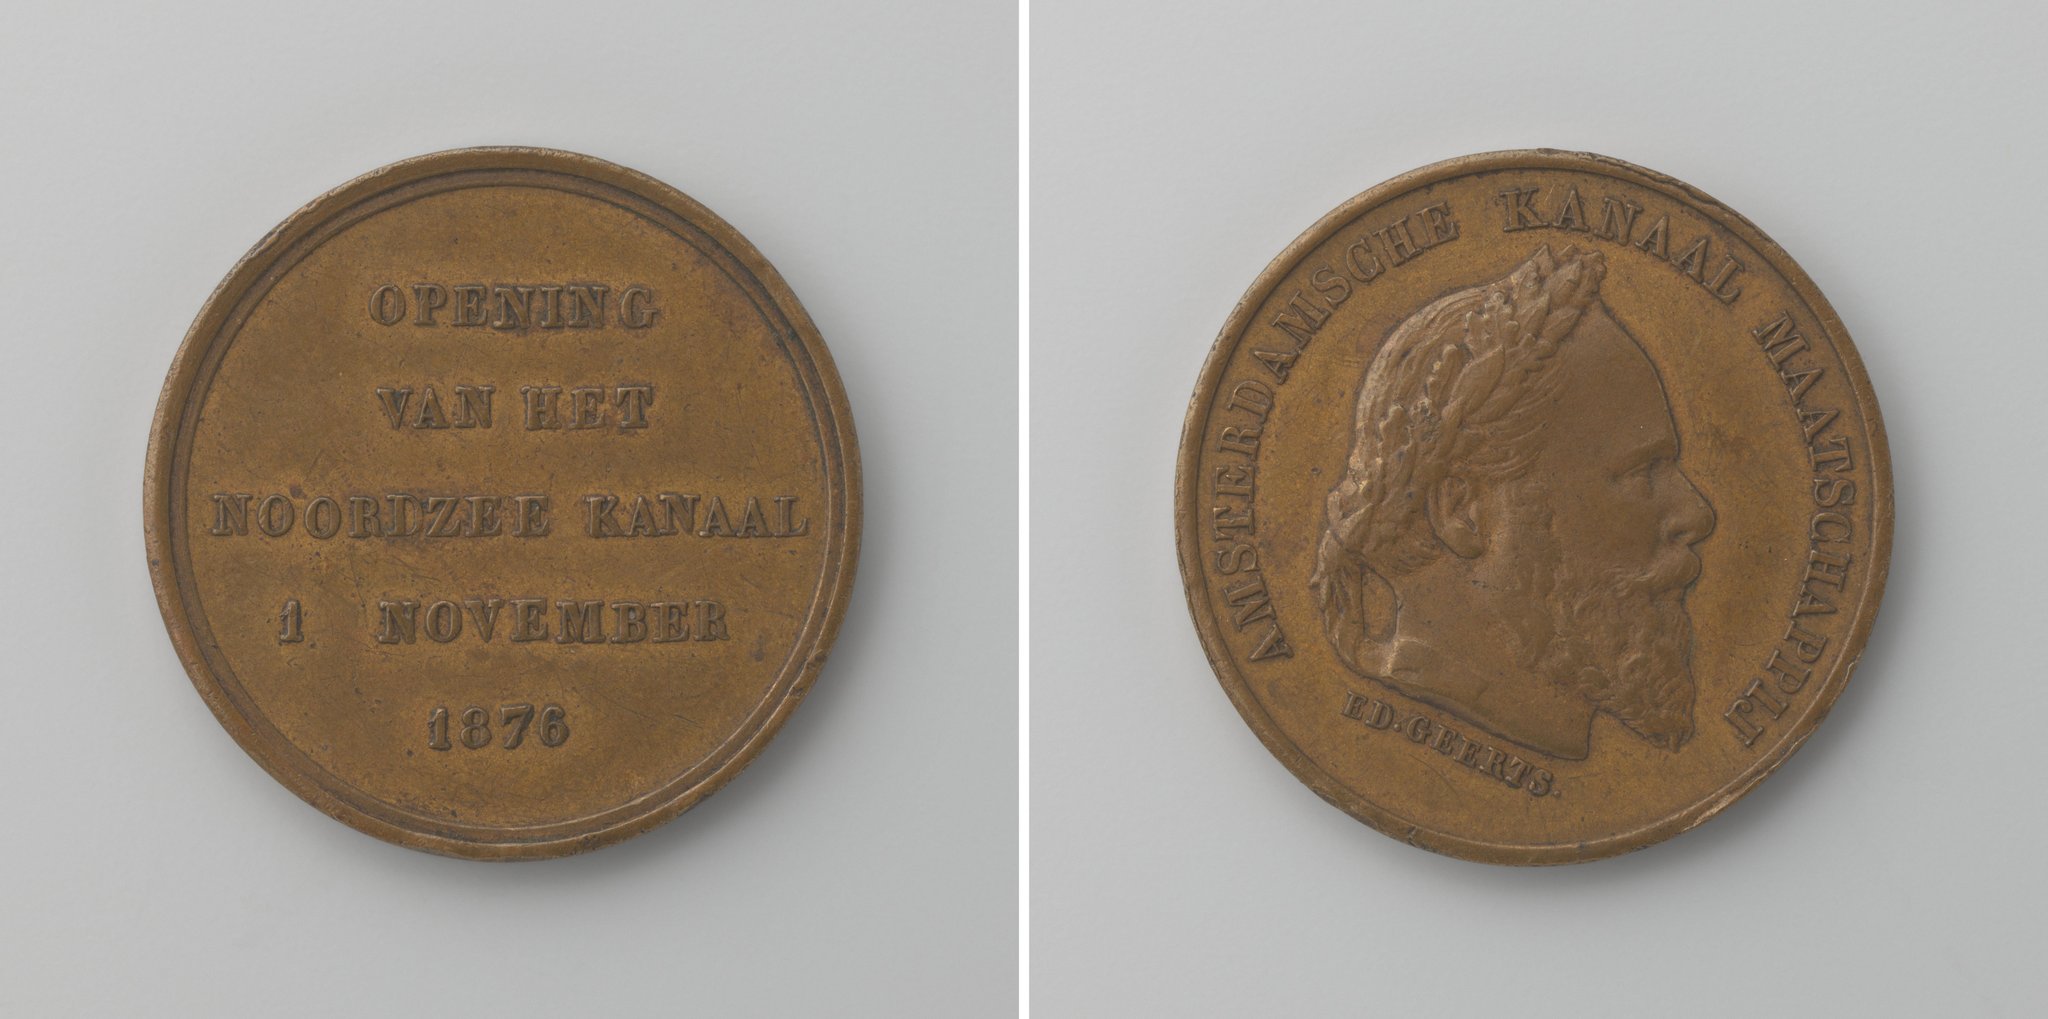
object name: history medal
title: Opening van het Noordzeekanaal 1876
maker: edouard louis geerts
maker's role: medailleur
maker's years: 1846-1889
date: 1876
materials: brass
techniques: striking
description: Messing penning, op de voorzijde het portret van Koning Willem III naar rechts met eikenkrans, met omschrift, op de keerzijde vijf regels tekst.